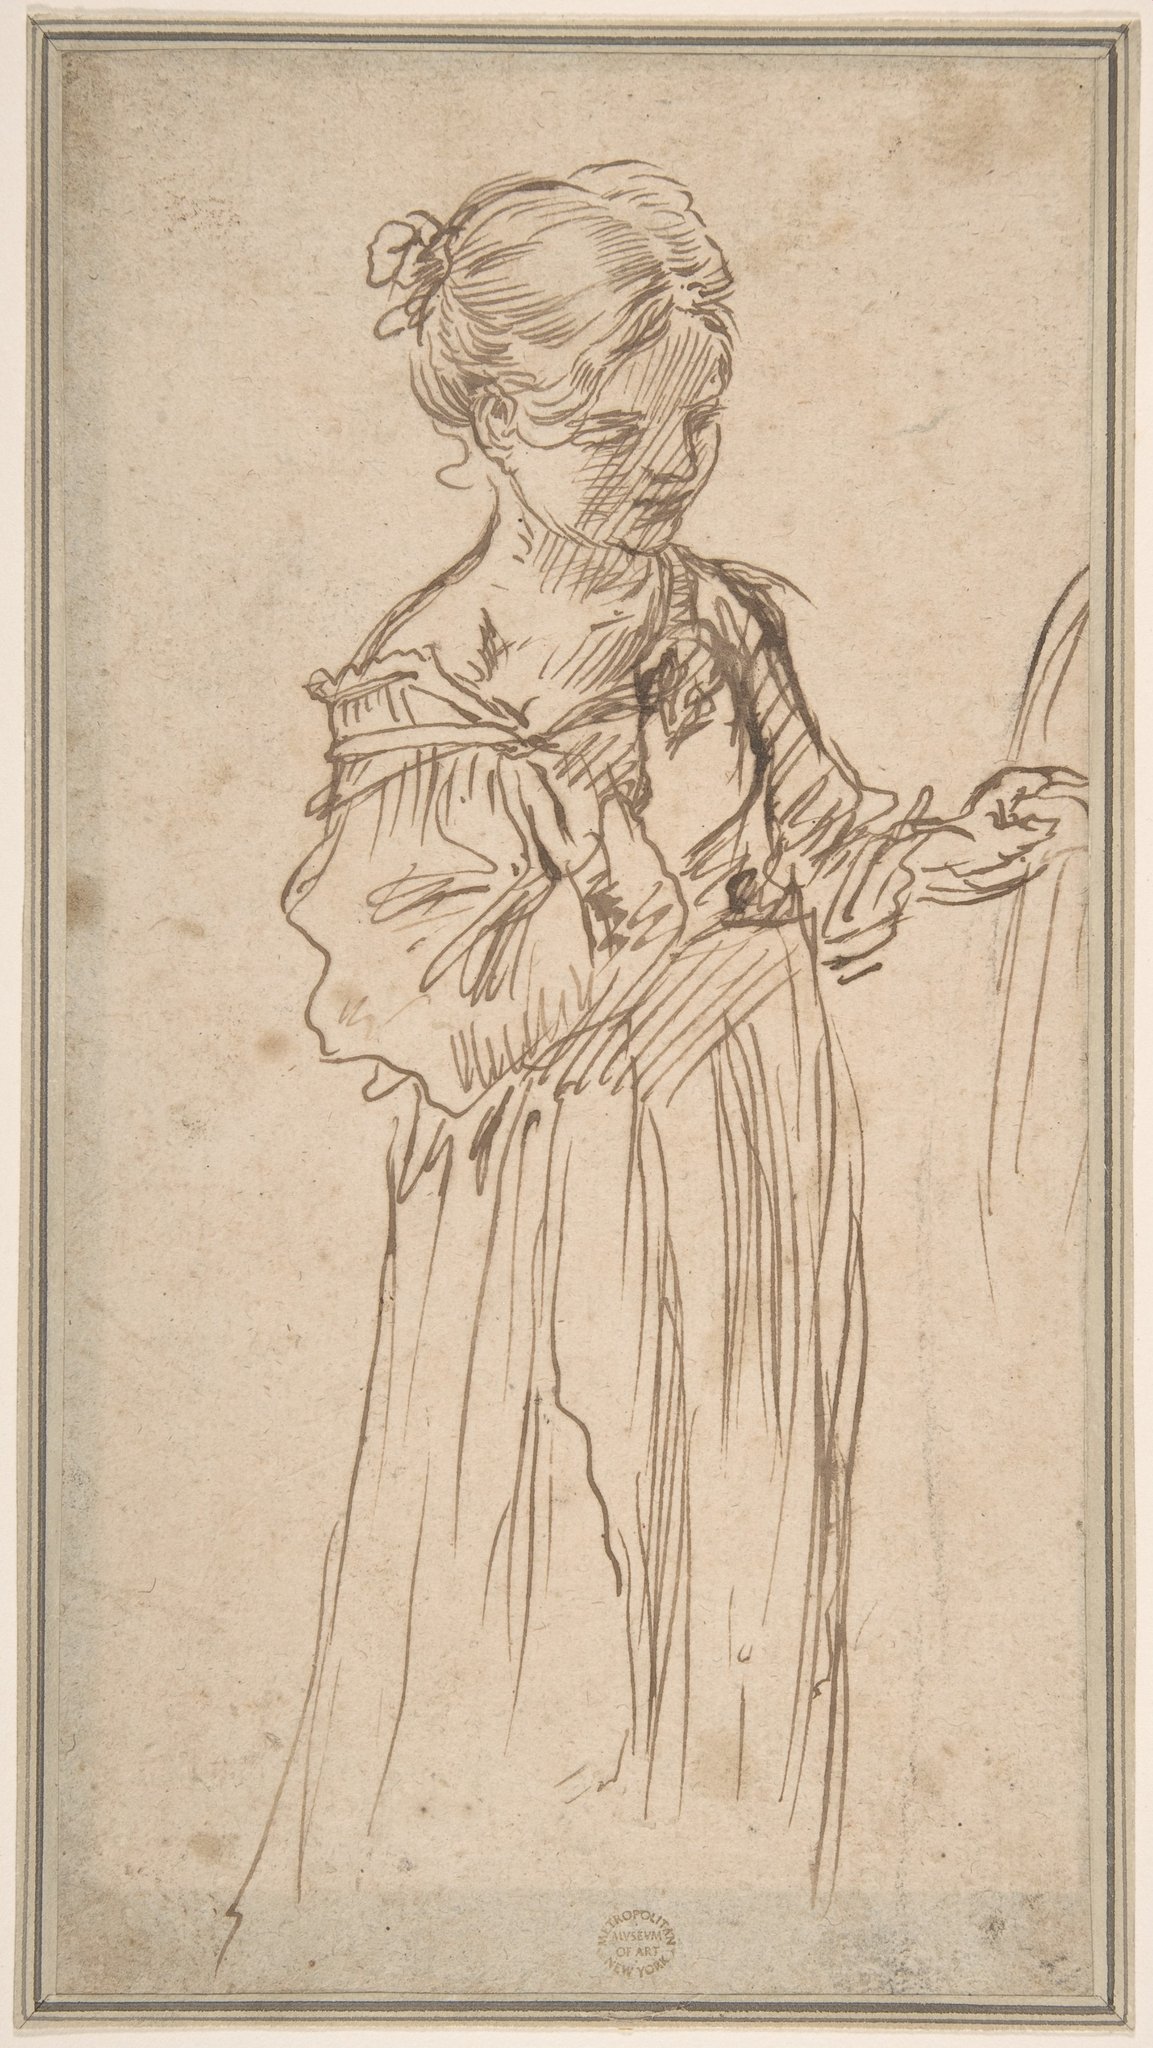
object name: drawing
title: Figure of a Girl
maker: anonymous, italian, roman-bolognese, 17th century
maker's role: artist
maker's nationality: italian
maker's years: 1600-1700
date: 1601-1700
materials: chalk, ink, paper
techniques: pen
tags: girls